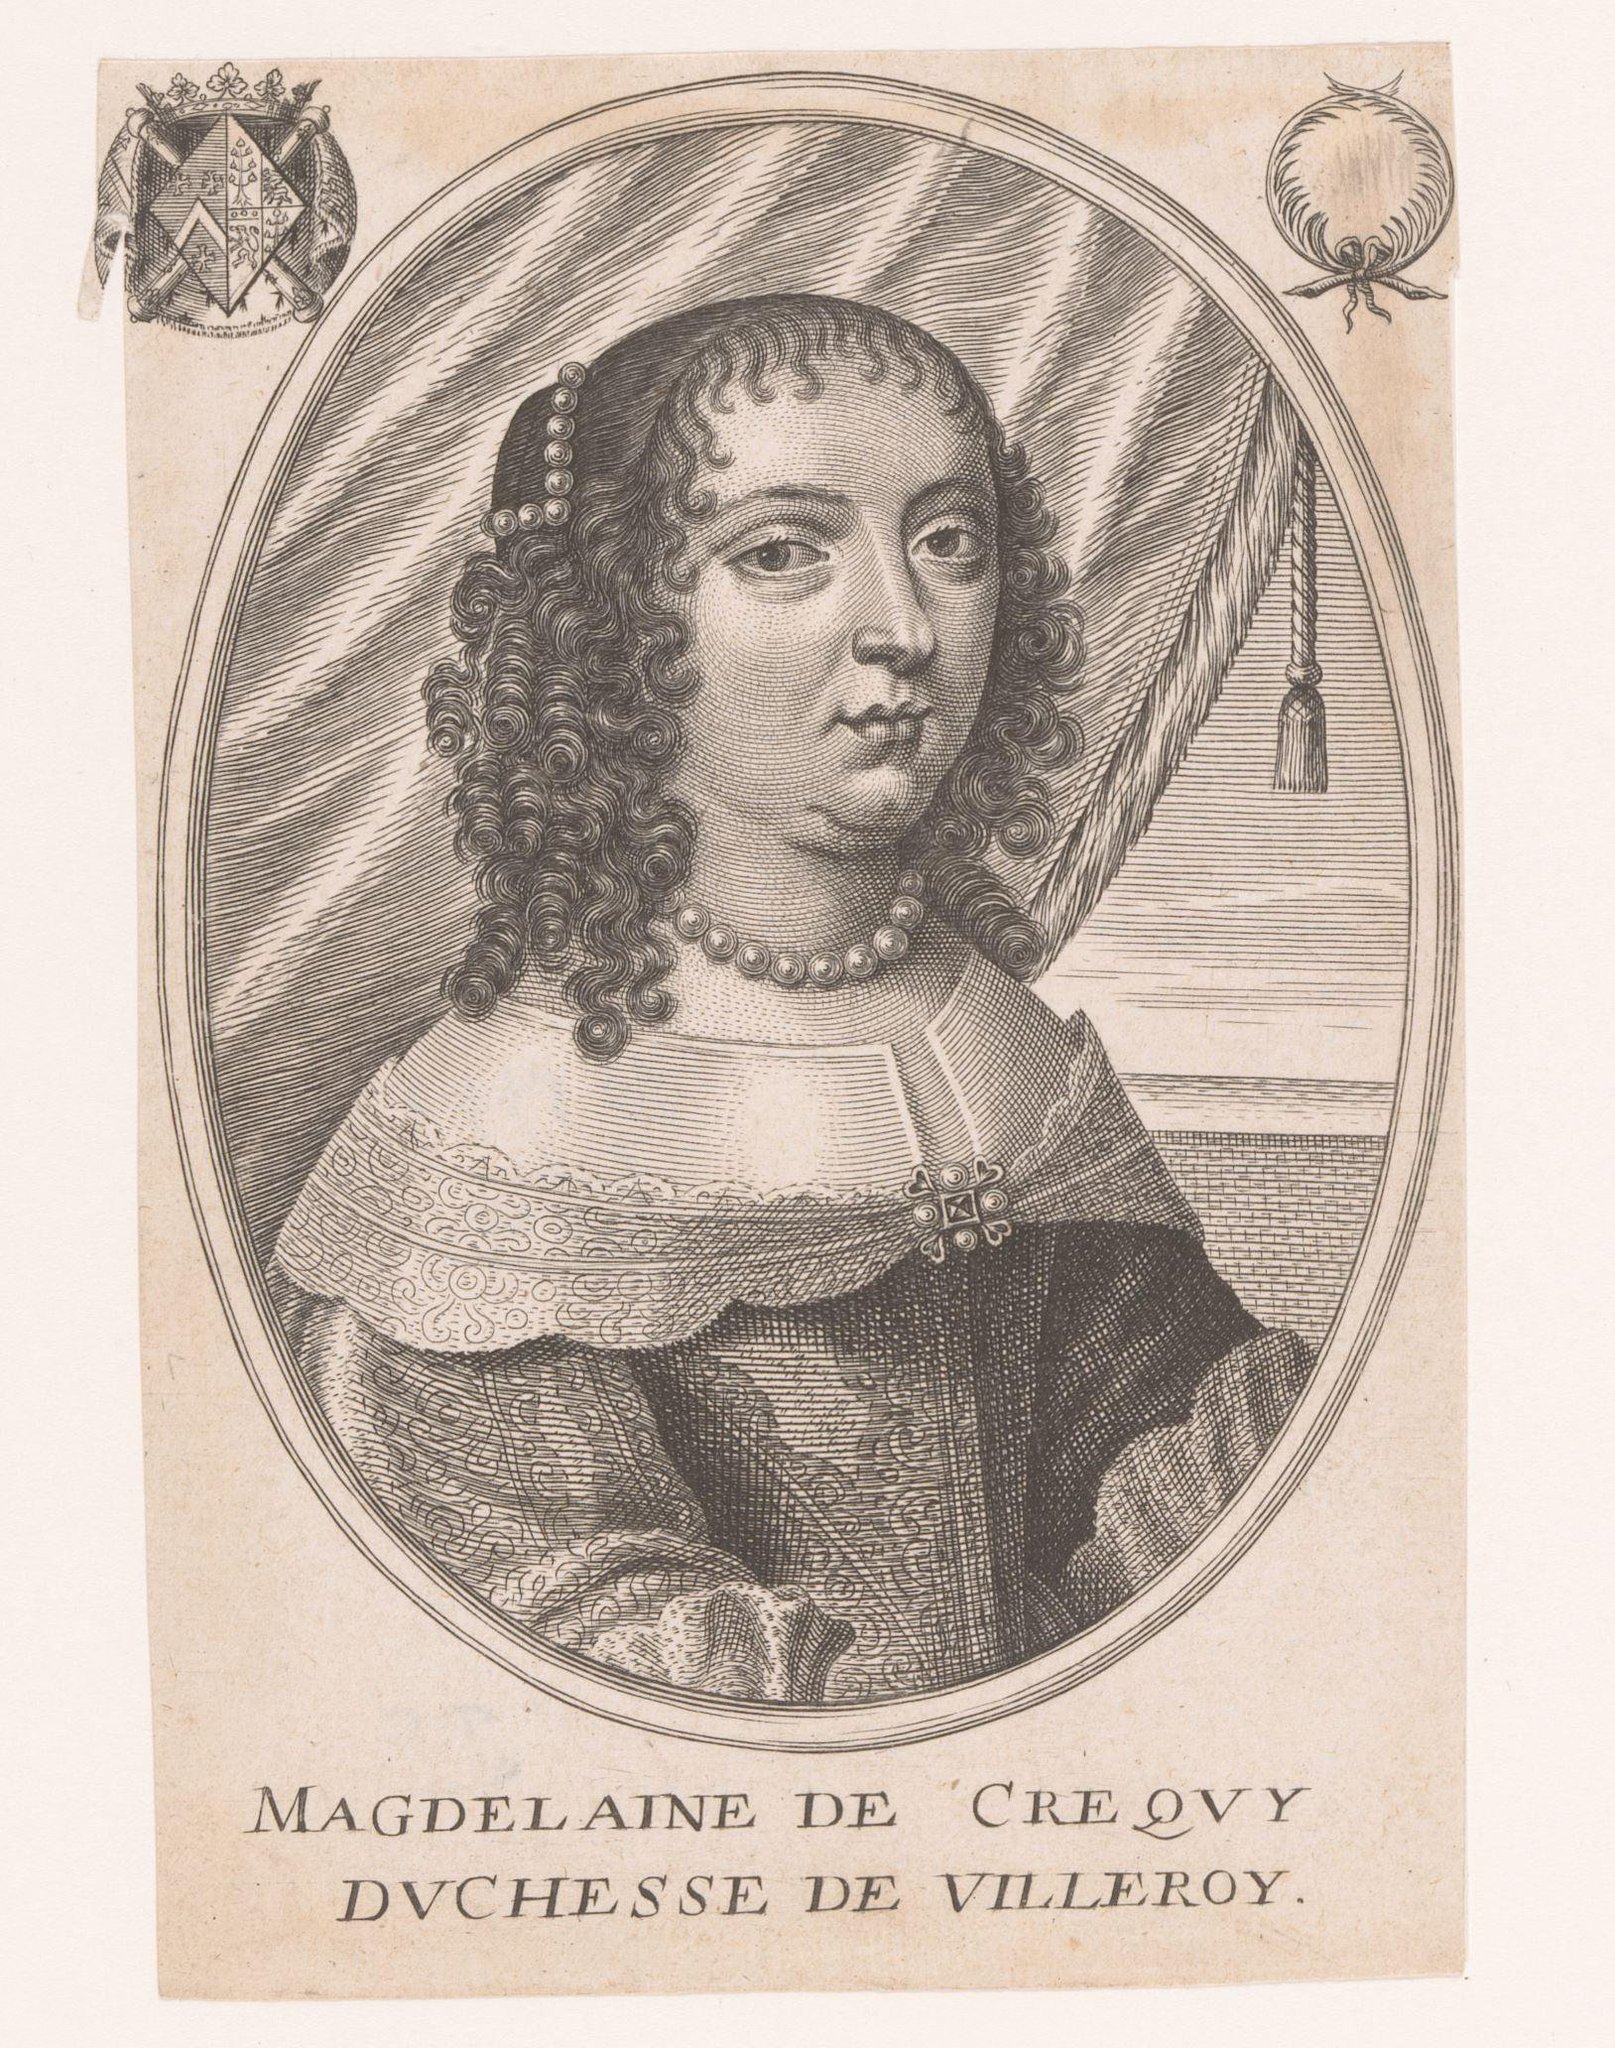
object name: print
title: Portret van Madeleine de Créquy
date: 1660-1668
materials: paper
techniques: engraving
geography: paris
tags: historical persons - bb - woman, armorial bearing, heraldry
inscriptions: collector's mark: Lugt 2228, collector's mark: Lugt 357